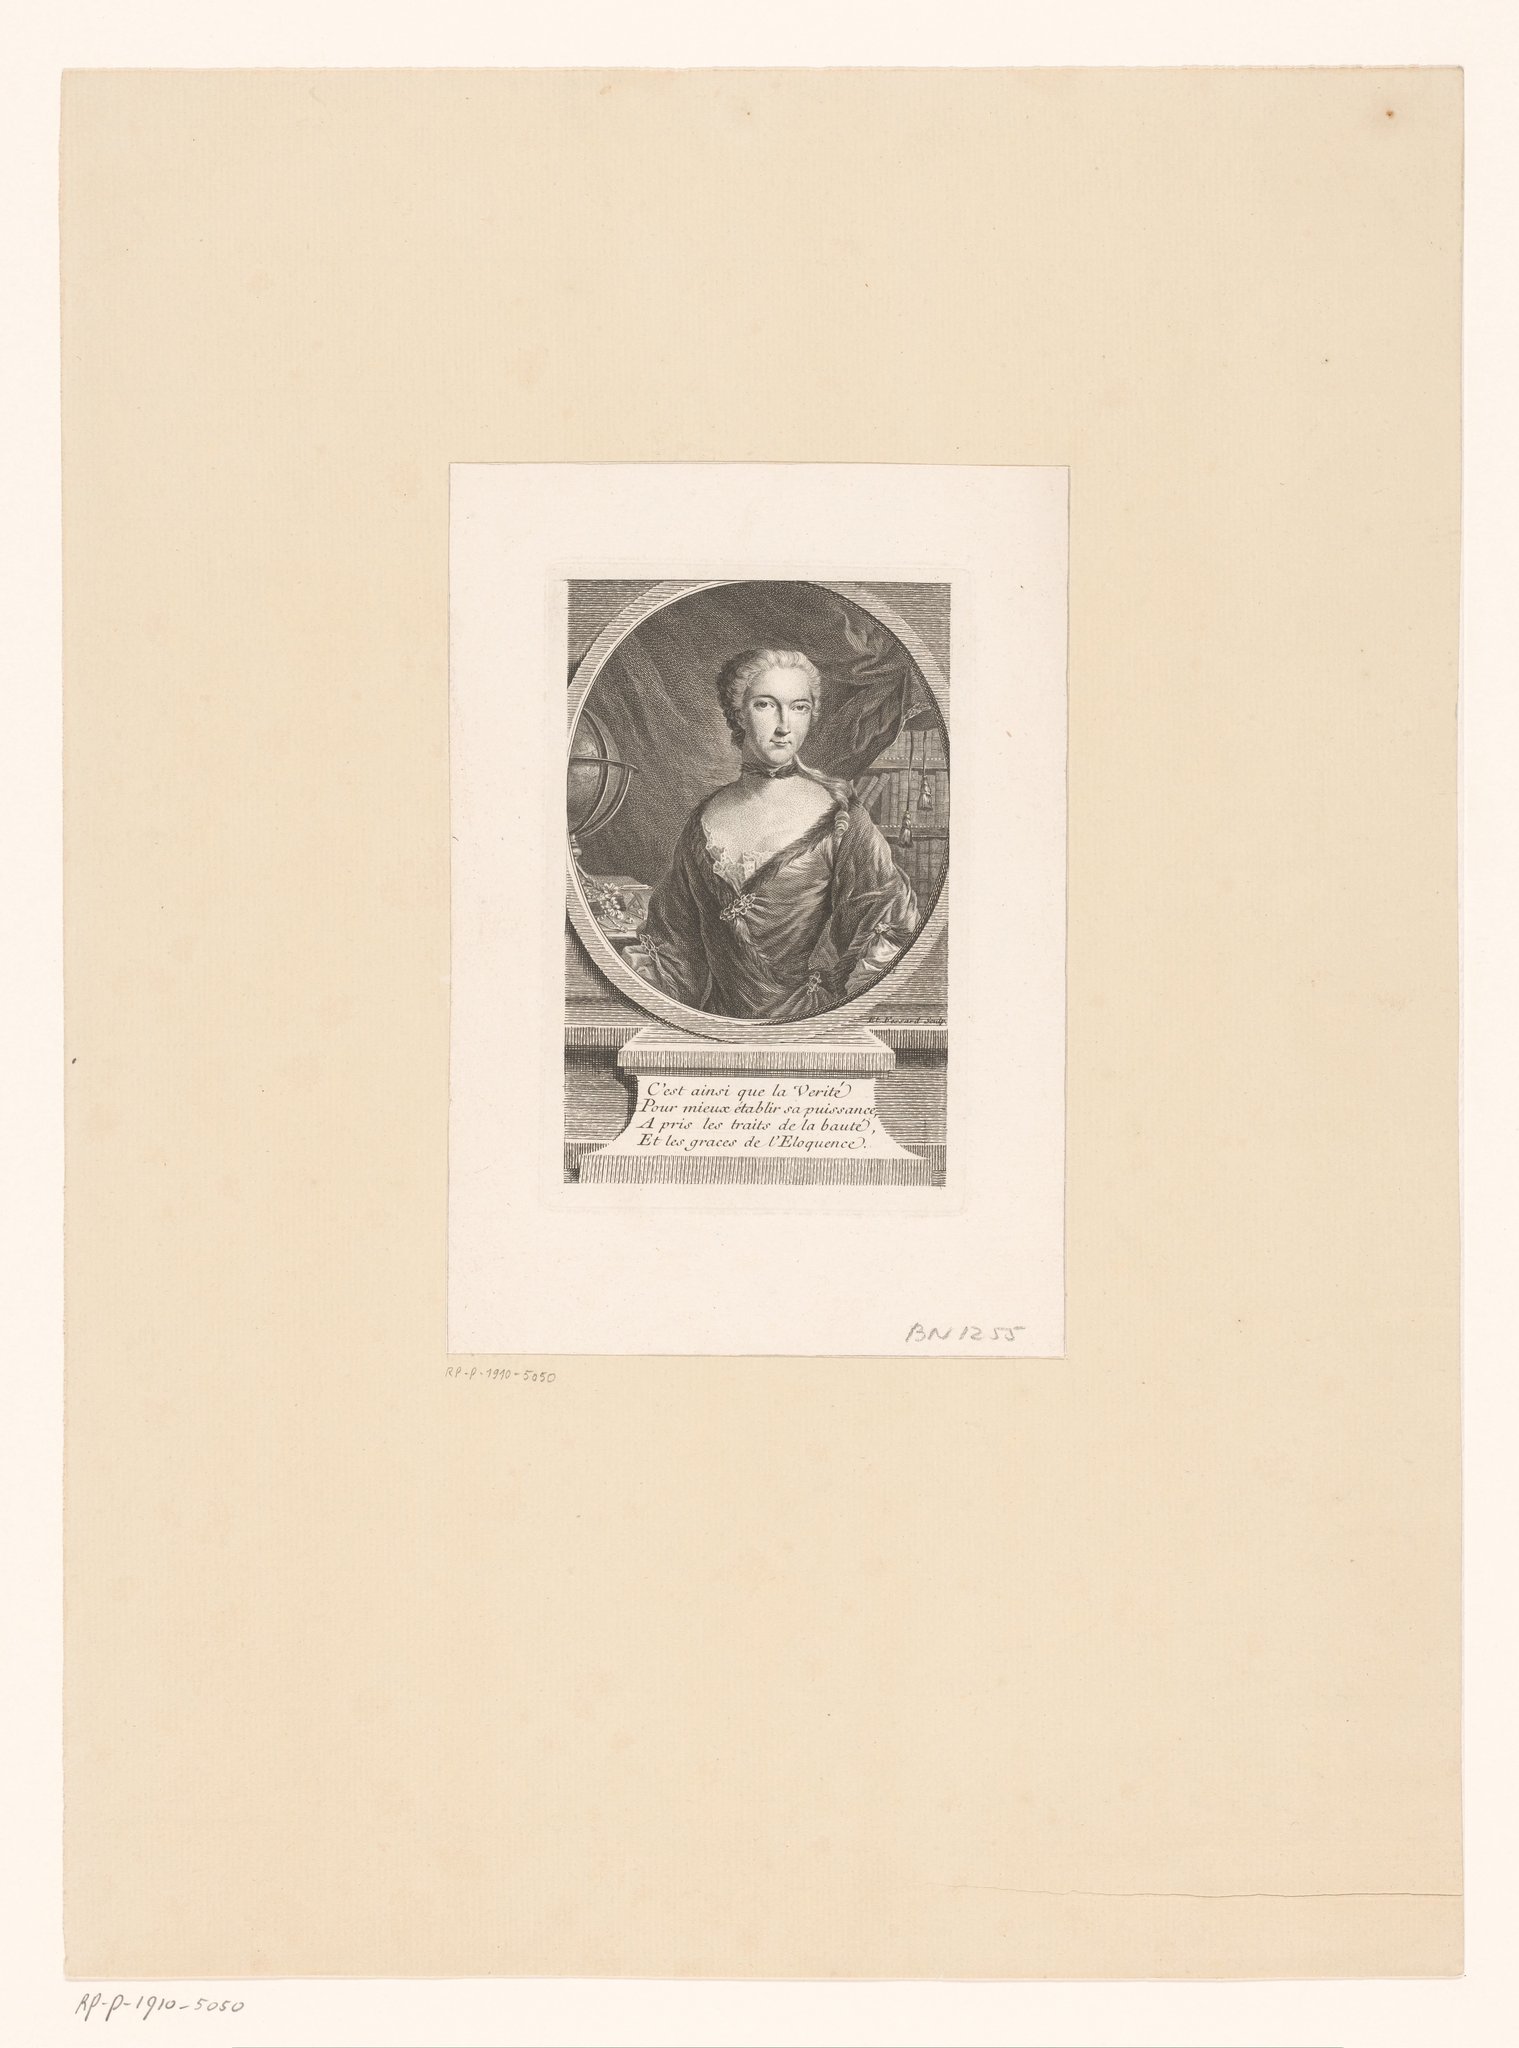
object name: print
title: Portret van Émilie du Châtelet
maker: etienne fessard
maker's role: print maker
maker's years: 1714-1777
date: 1724-1777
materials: paper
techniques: engraving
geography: france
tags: scholar in his study, historical persons - bb - woman, ornament ~ medallion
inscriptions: collector's mark: Lugt 2228